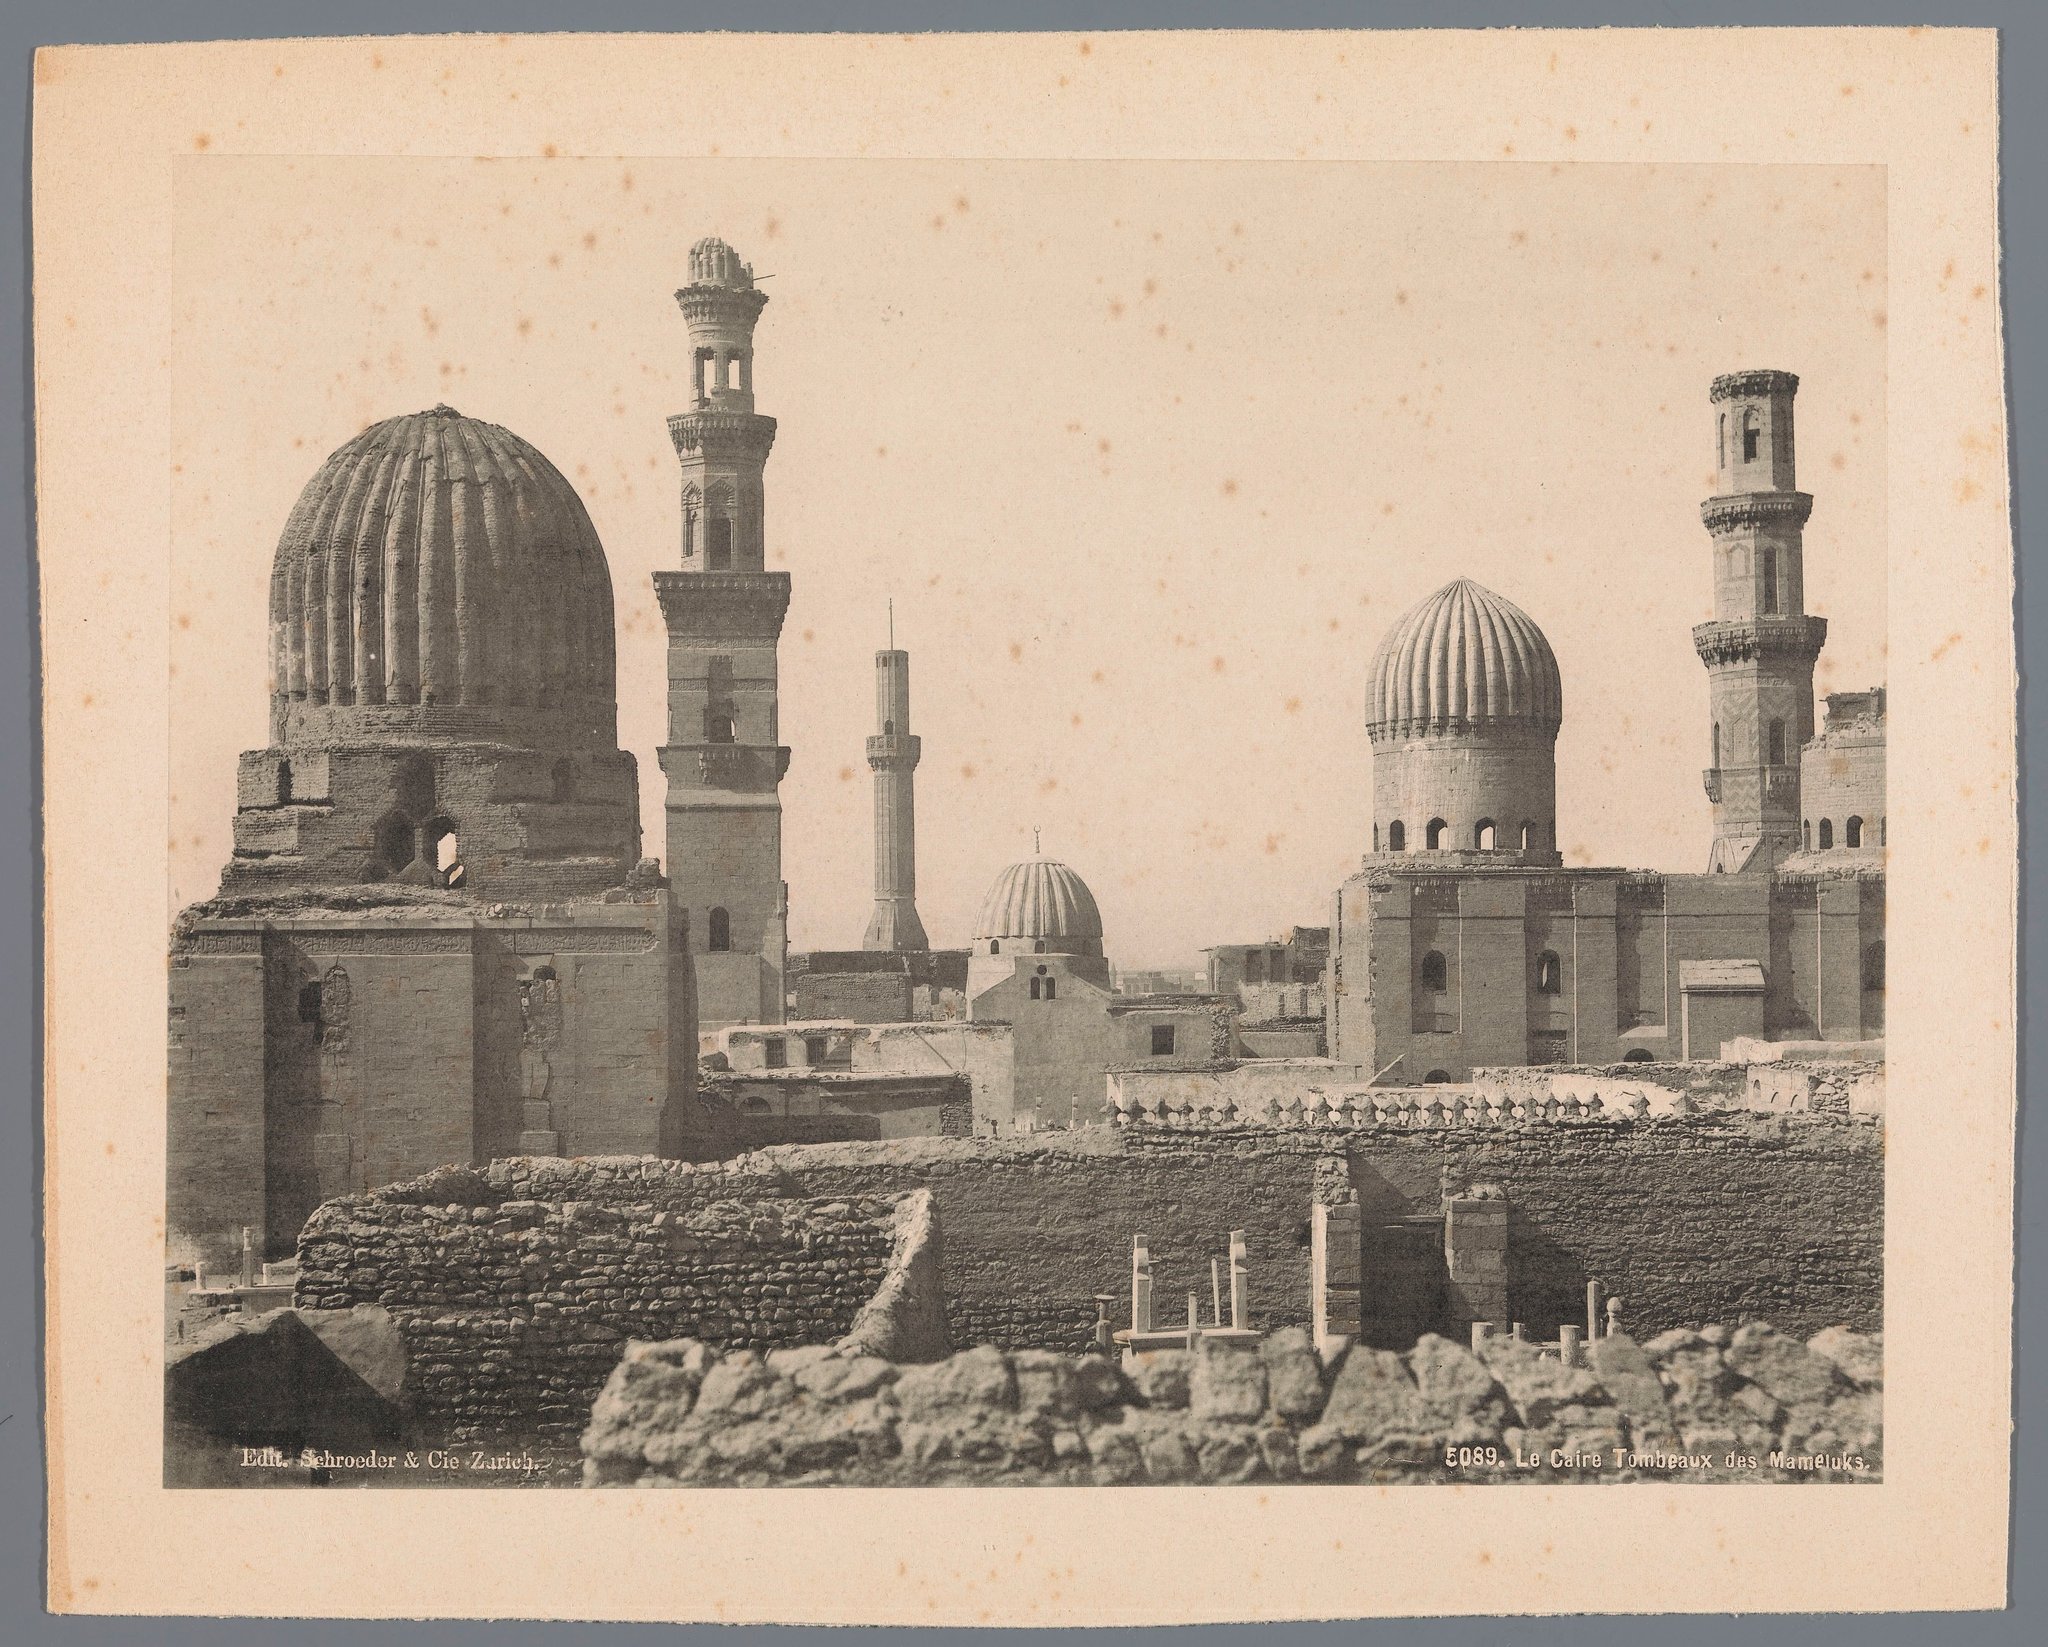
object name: photograph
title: Le Caire Tombeaux des Mameluks.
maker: Anonymous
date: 1875-1900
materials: cardboard, paper, ink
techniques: photograph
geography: zurich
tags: grave, tomb, slavery; serfs and enslaved persons, temple, shrine ~ islam, mohammedanism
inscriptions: collector's mark: ‘KUNSTNIJVERHEIDSCHOOL QUELLINUS AMSTERDAM FRANS HALSSTRAAT 14.’, number: ‘5089.’, collector's mark: ‘INSTITUUT VOOR KUNST-NIJVERHEIDSONDERWIJS GABRIËL METSUSTRAAT No. 16 AMSTERDAM’